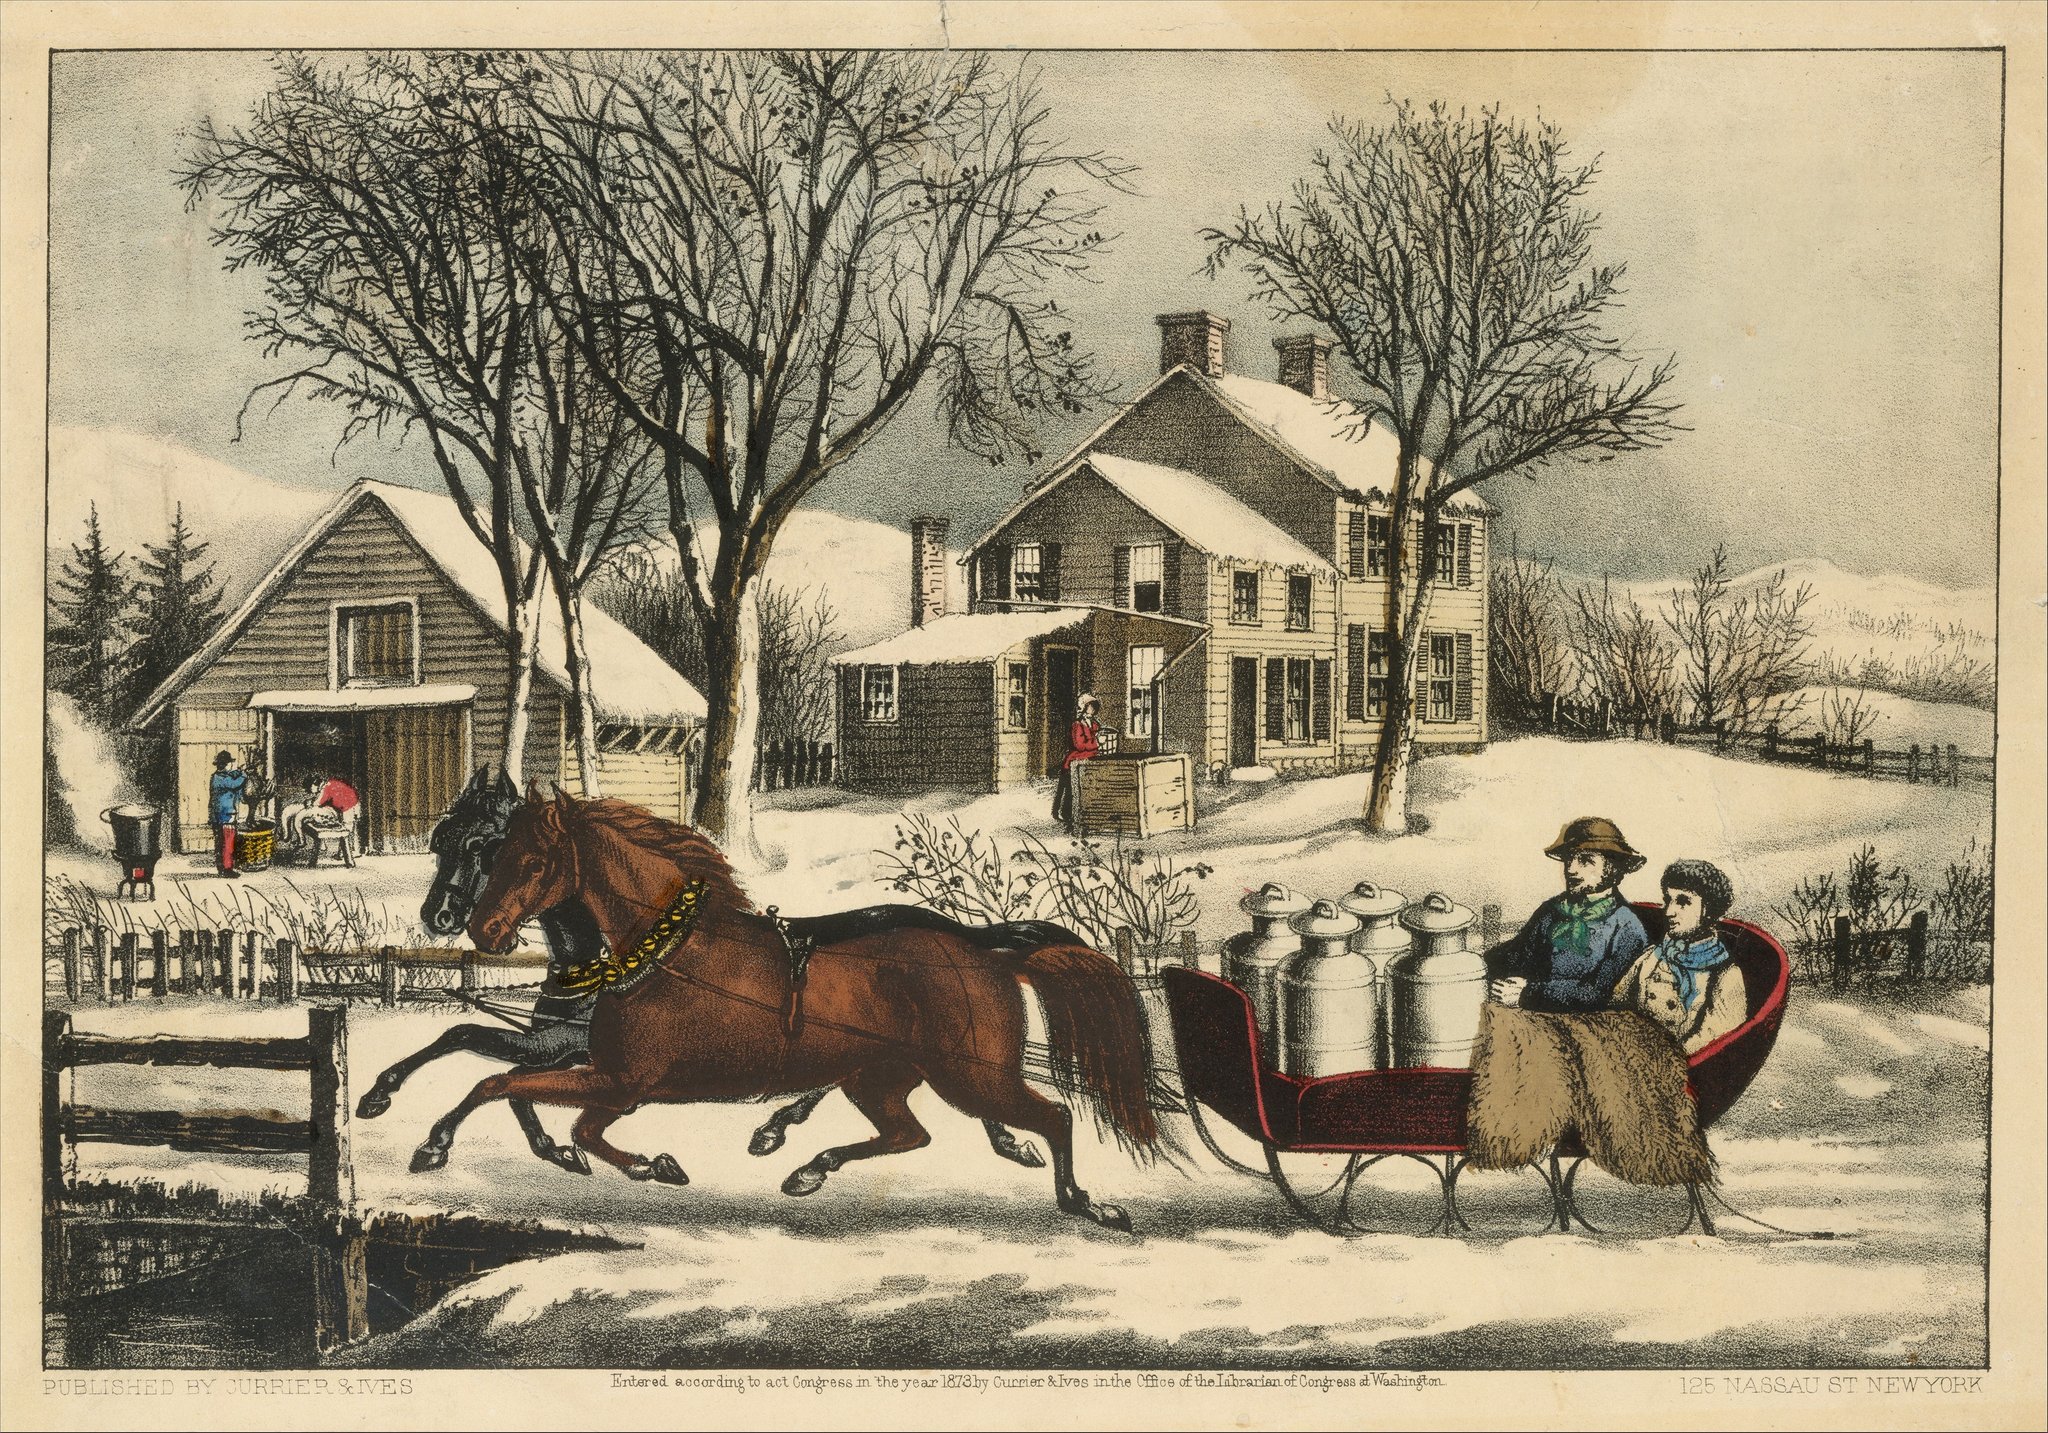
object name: print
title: Winter Morning in the Country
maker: currier & ives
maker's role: publisher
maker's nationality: american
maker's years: 1857-1907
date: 1873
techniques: hand coloring, lithograph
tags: houses,winter,morning,carriages